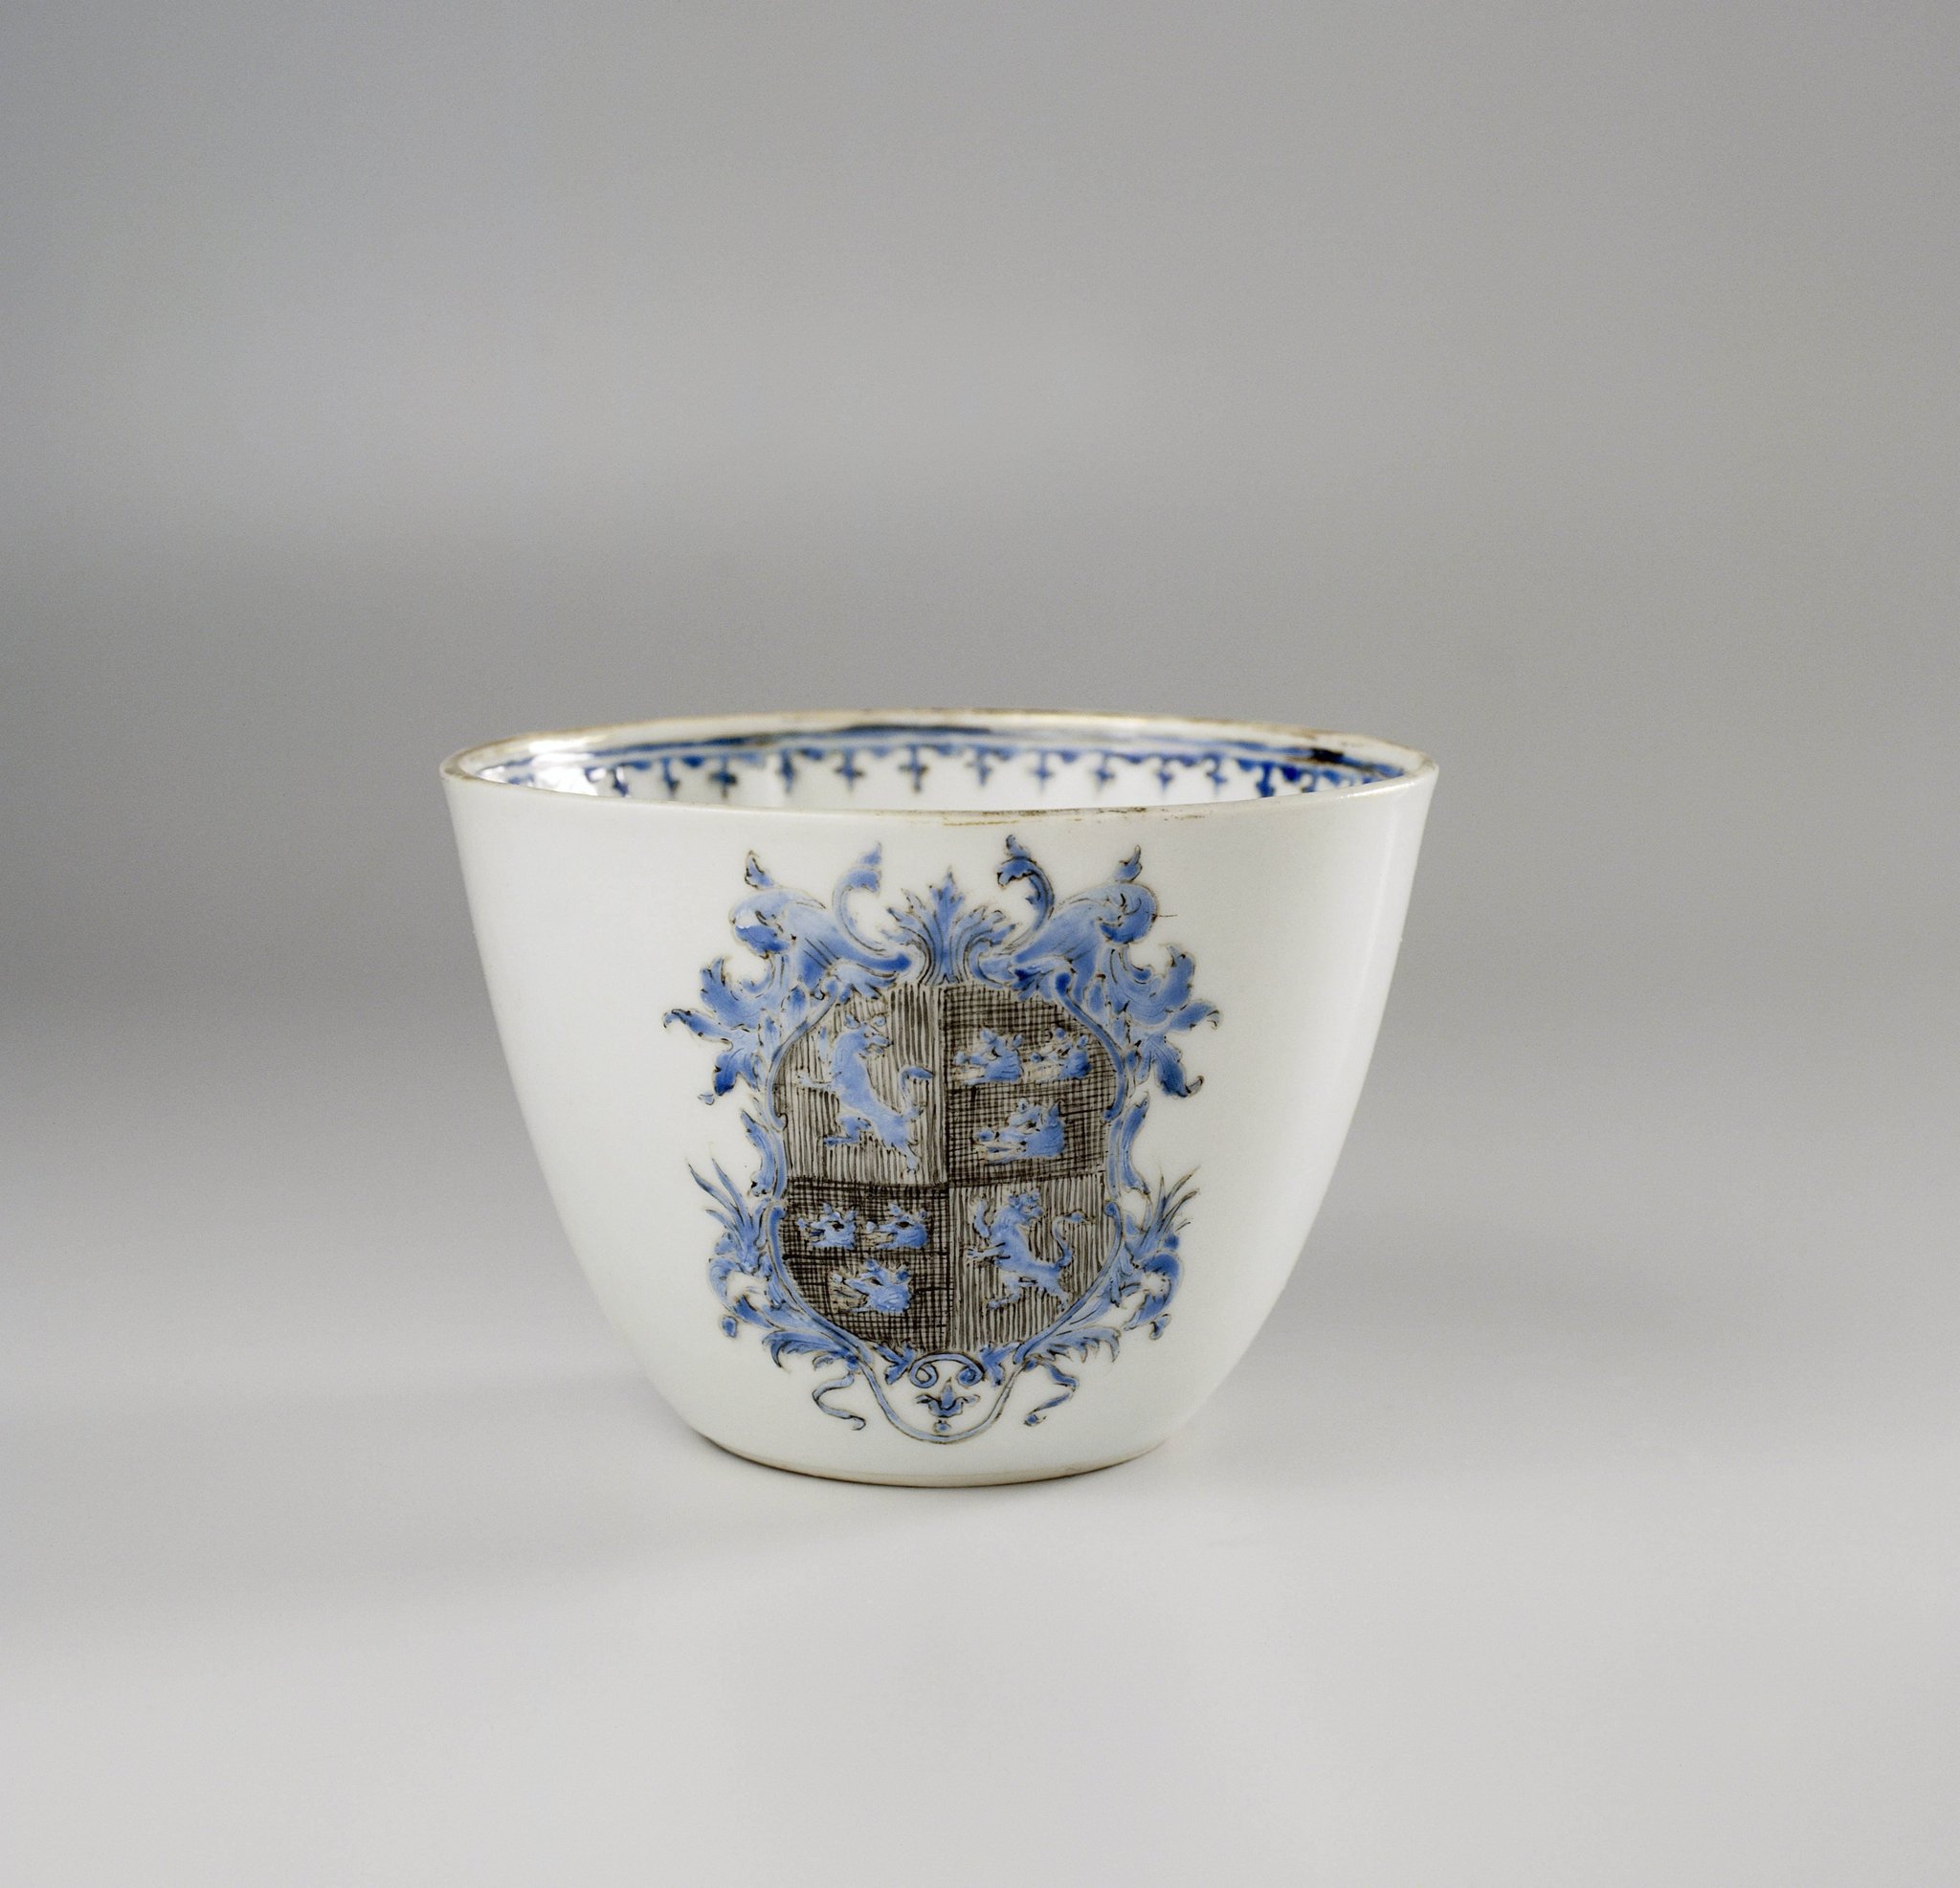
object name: cup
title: Cup with a coat of arms and a spearhead-border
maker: Anonymous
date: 1740-1760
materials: glaze, gold, paint, porcelain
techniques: firing, gilding, turning, vitrification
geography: china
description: Kop van porselein met een rechte wand, beschilderd op het glazuur in blauw, zwart en goud. Op de buitenwand een familiewapen omgeven door bladranken. Het wapen is verdeeld in vier vakken met in 1. en 4. een leeuw op een zwart gearceerde grond; 2. en 3. met drie zwijnenkoppen op een kruislings zwart gearceerde grond. De keerzijde van de kop met een leeuw. Op de binnenrand een spearhead-border. Wapenporselein in emailkleuren.